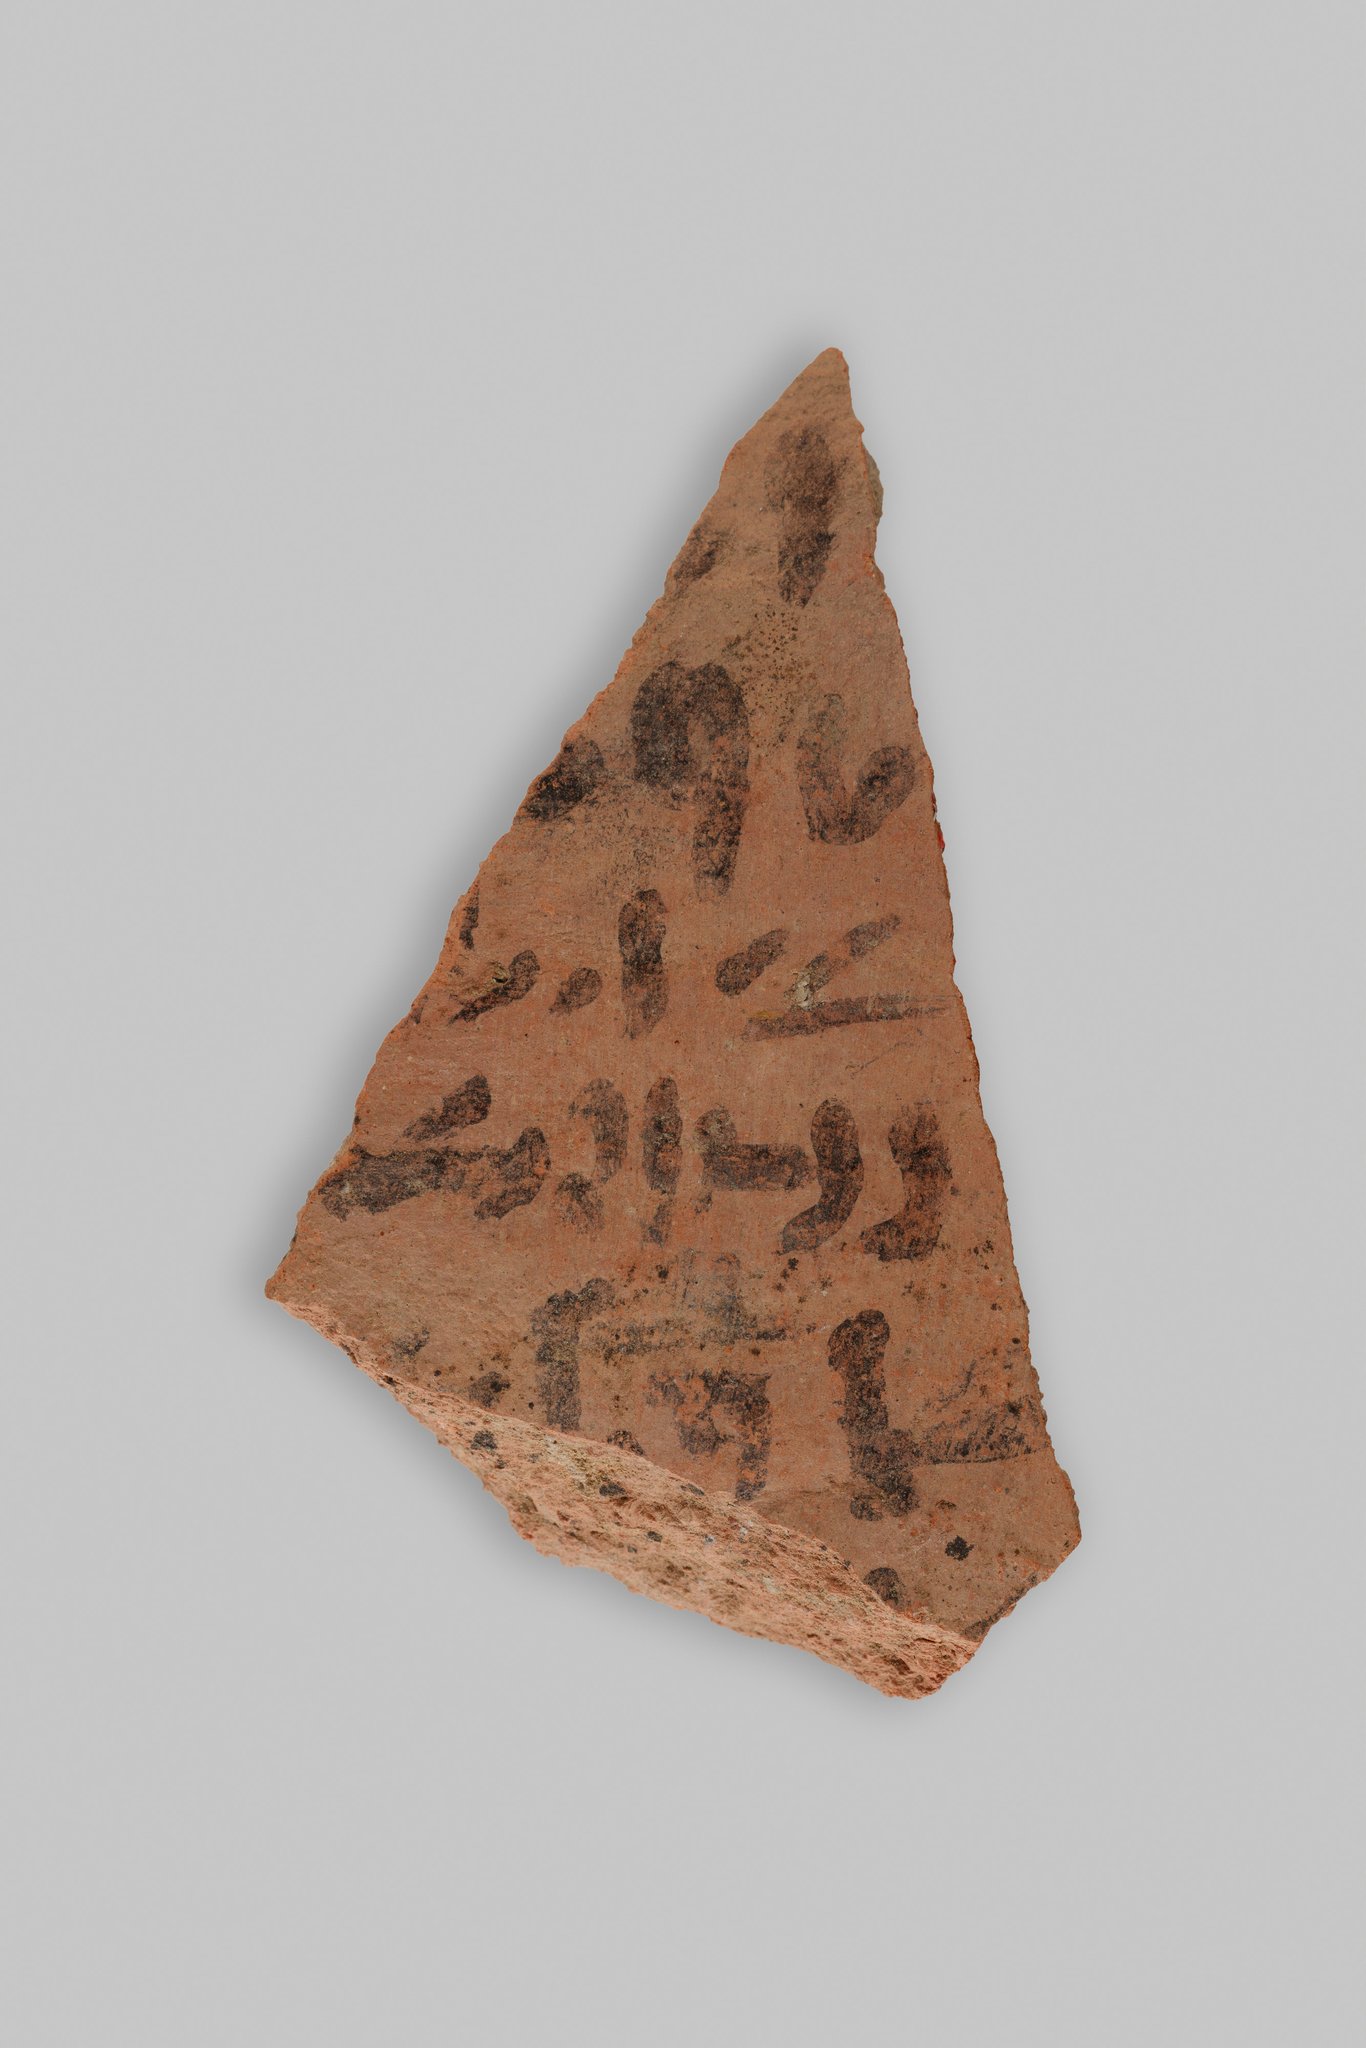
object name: ostracon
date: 400-30 BCE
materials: ink, pottery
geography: egypt